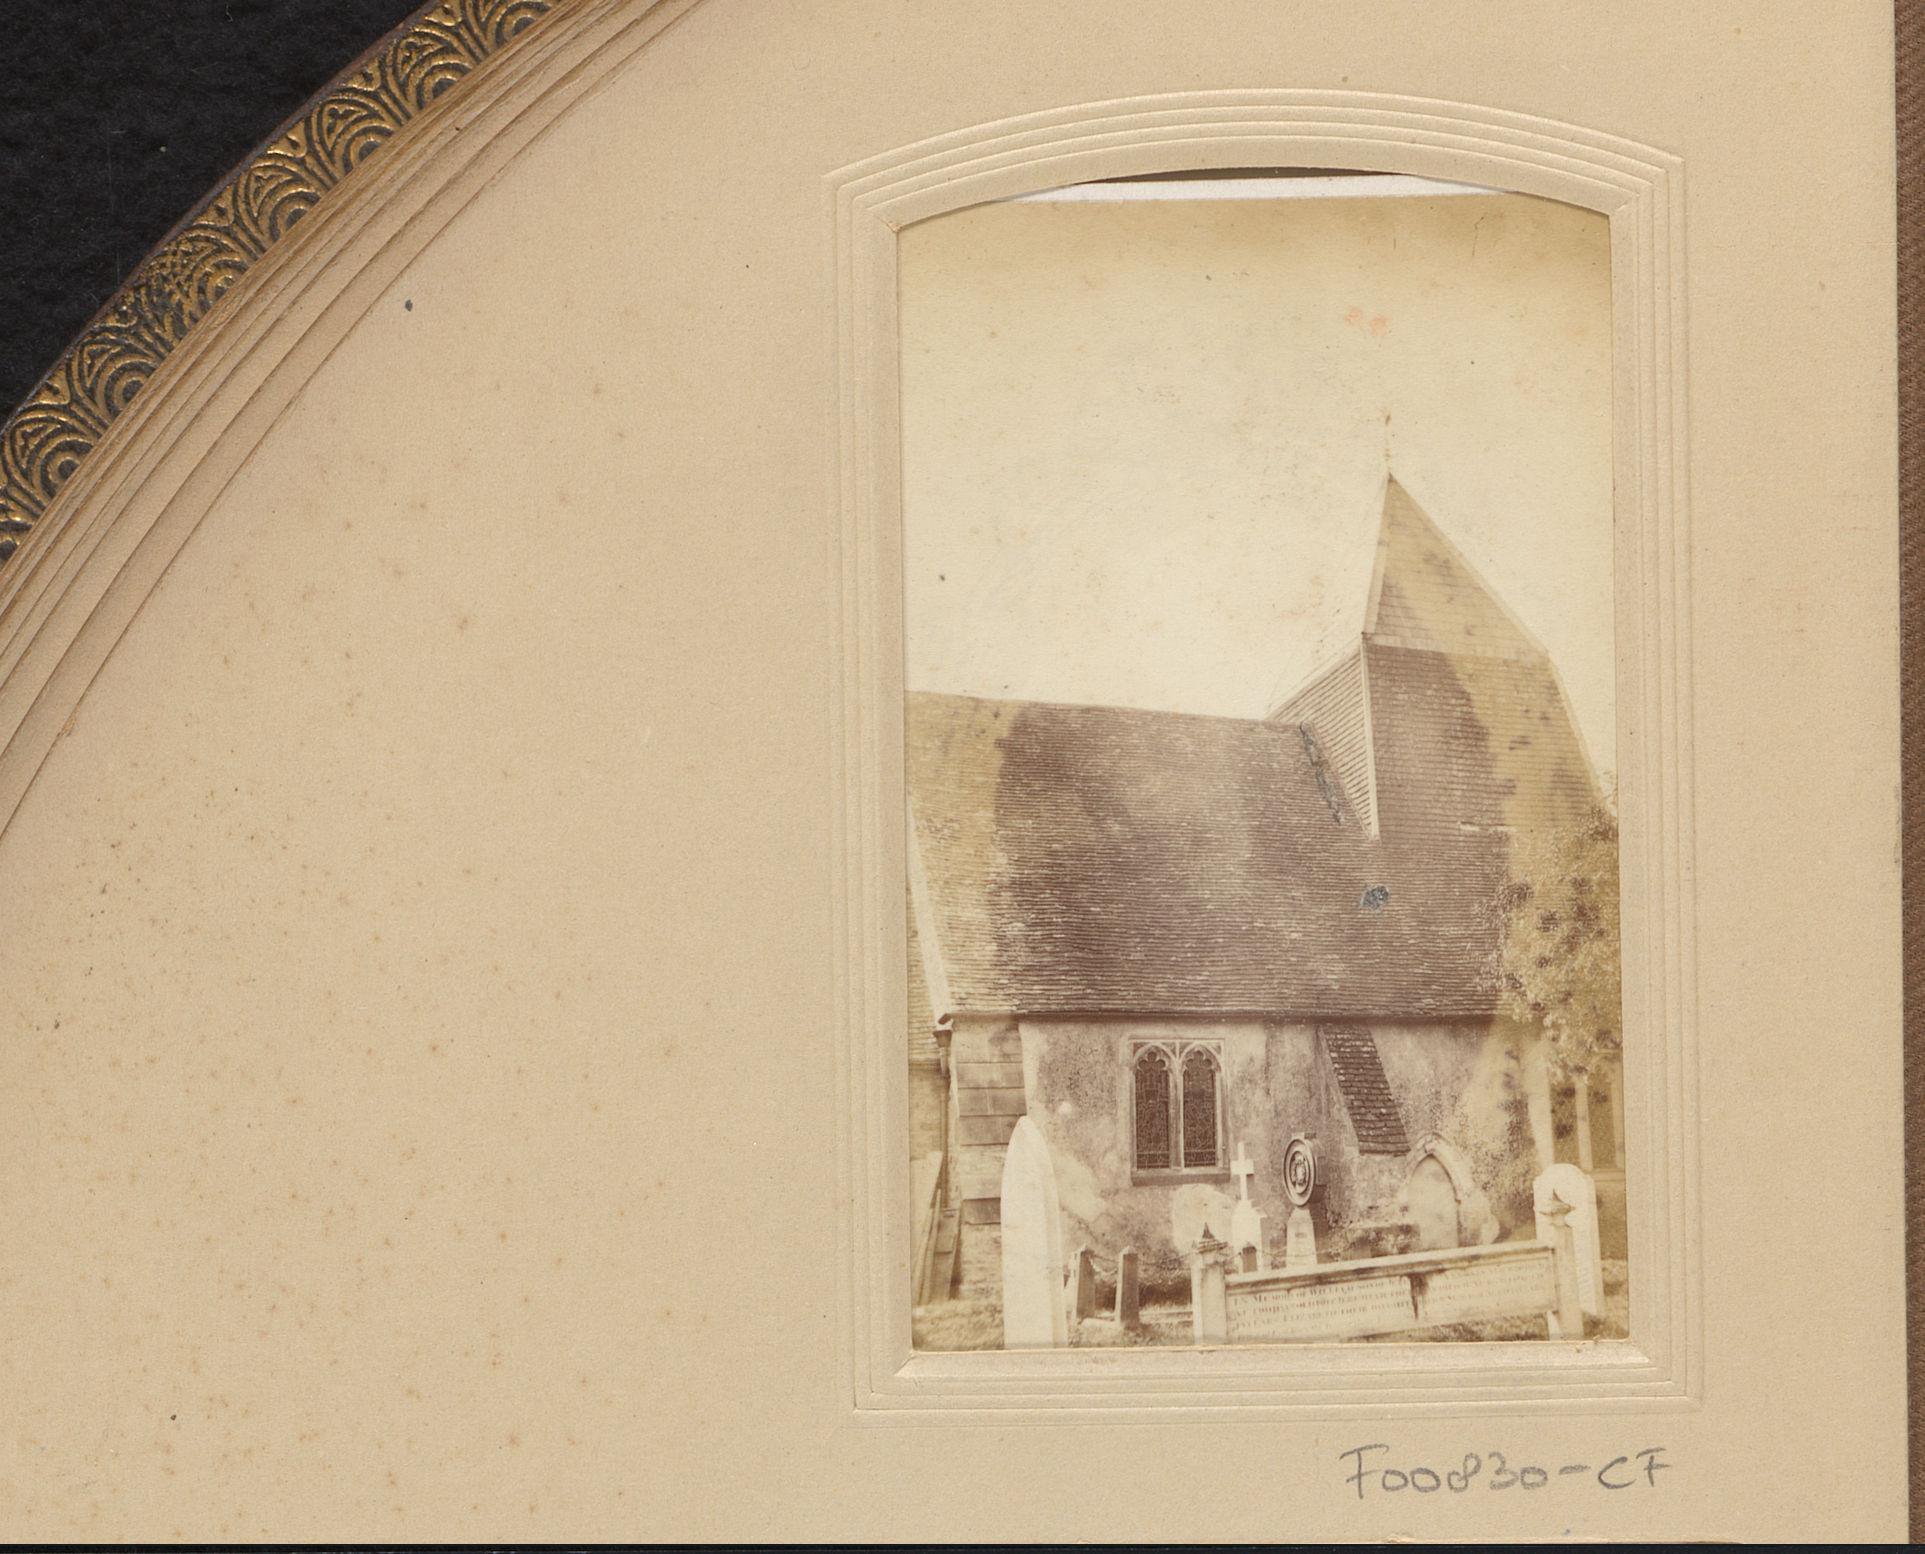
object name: album leaf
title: Church in the Wood te Hollingwood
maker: john wesley thomas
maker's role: fotograaf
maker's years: 1831-1908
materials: cardboard, photographic support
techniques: albumen print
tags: upright gravestone, church (exterior)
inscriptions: inscription: ‘(...)/ J.W. Thomas/ Photographer/ 45 George St/ Hastings’, annotation: ‘Hollington Church/ near Hastings’